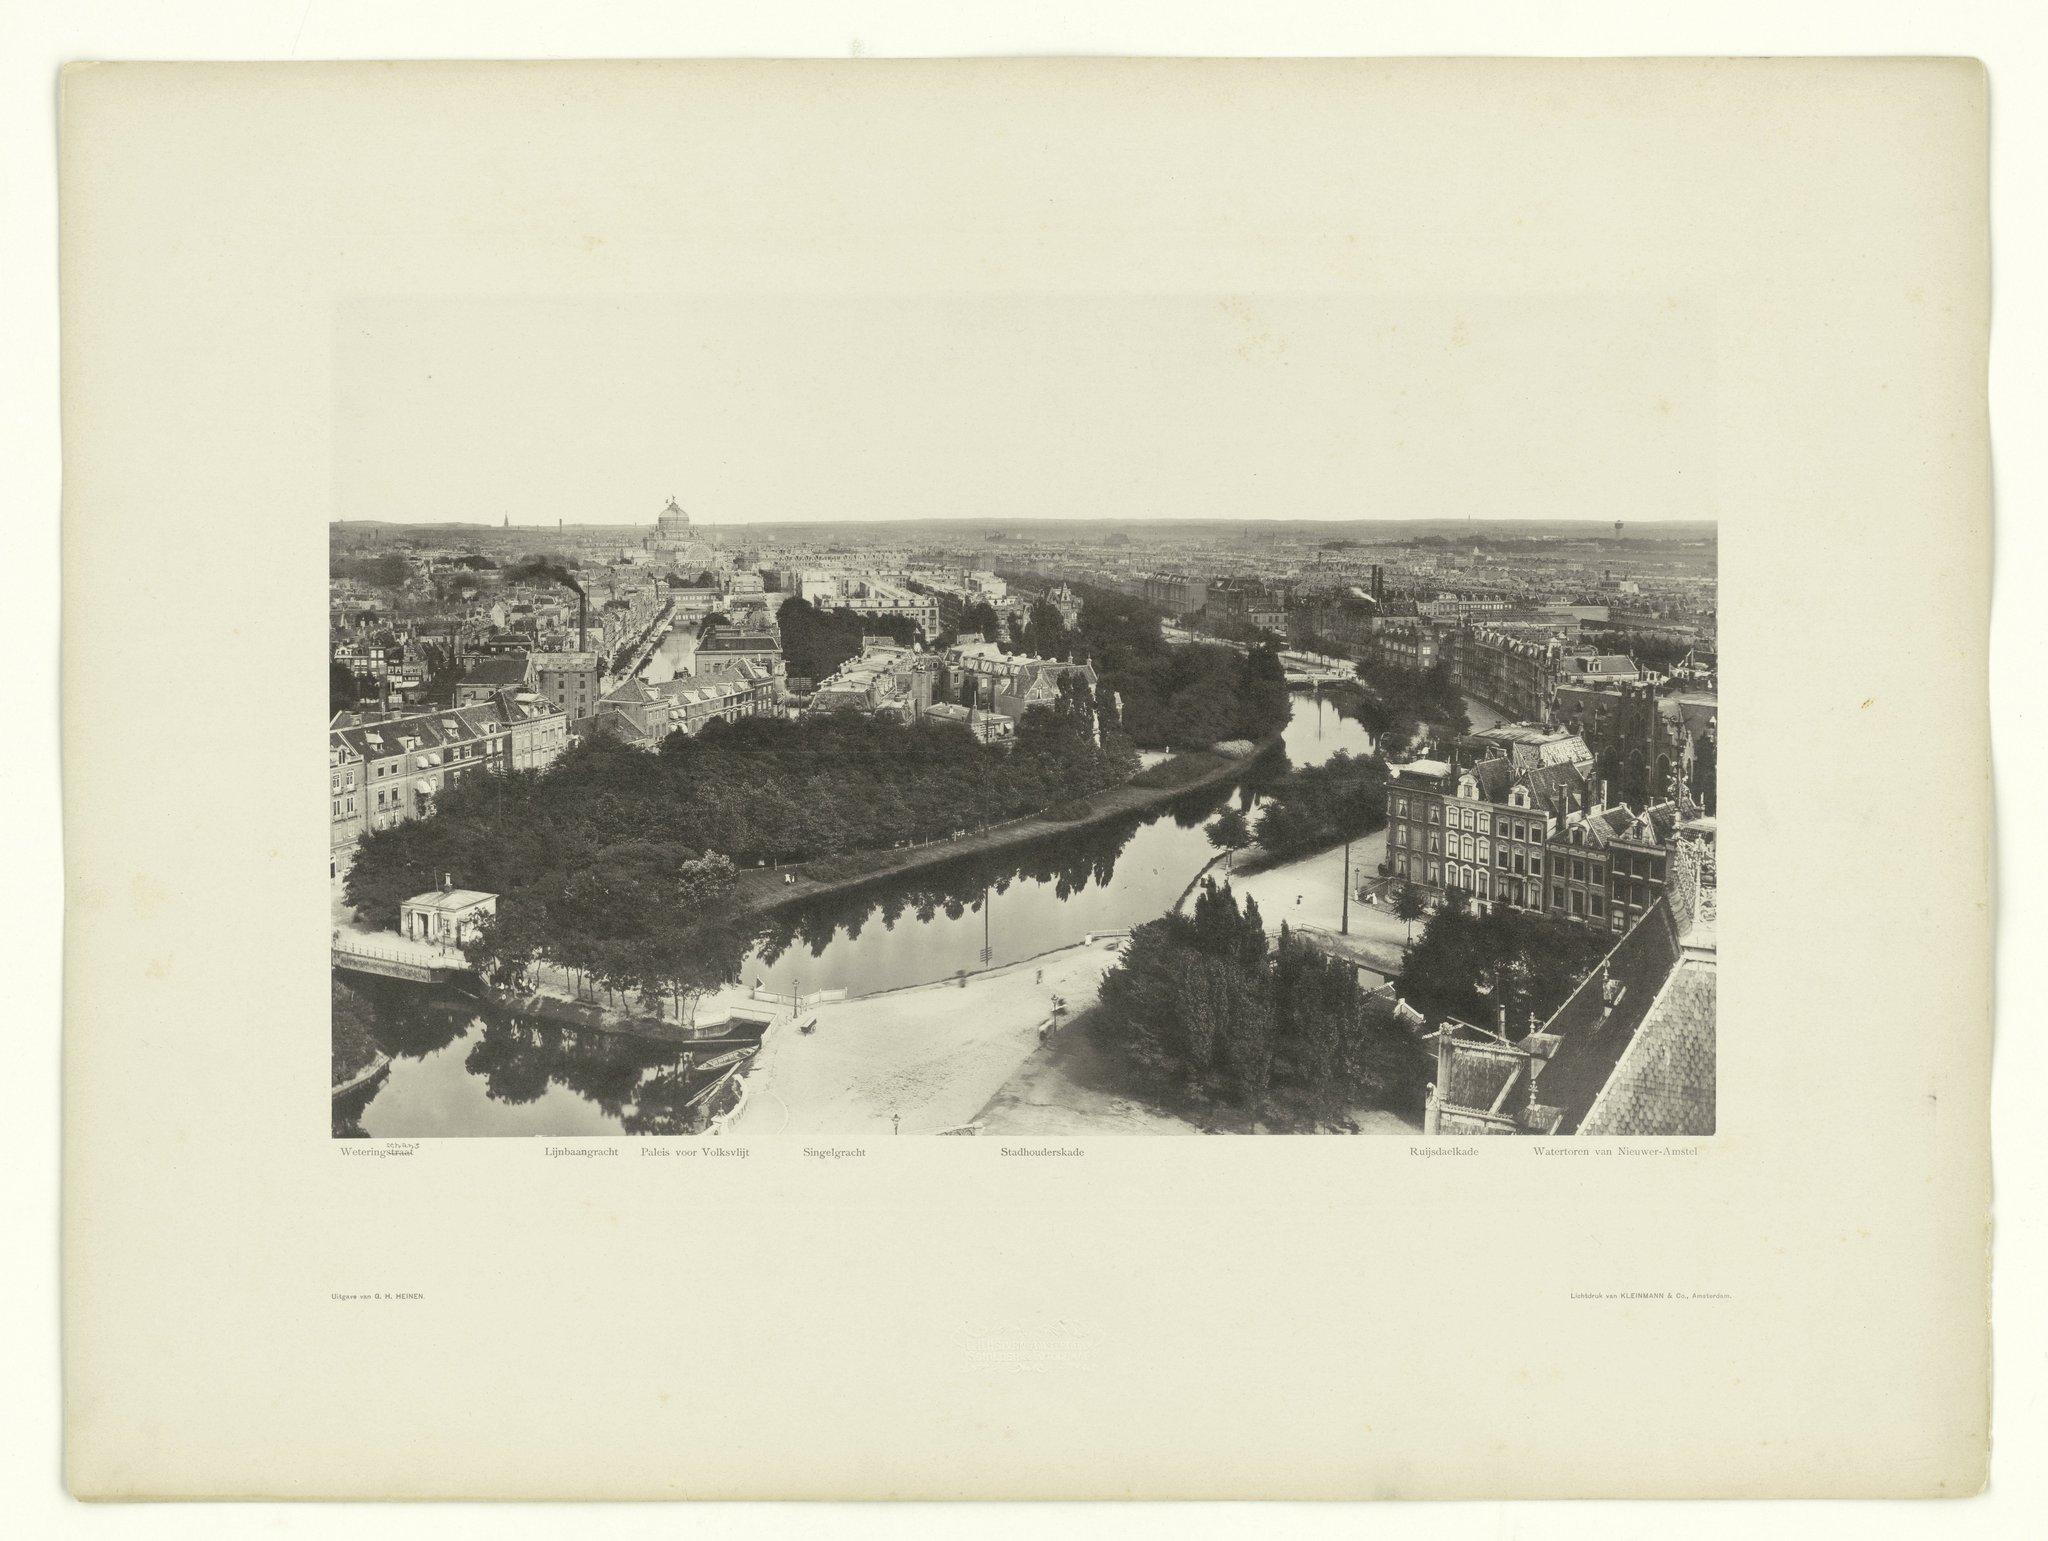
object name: photomechanical print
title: Weteringstraat, Lijnbaangracht, Paleis voor Volksvlijt, Singelgracht, Stadhouderskade, Ruijsdaelkade, Watertoren van Nieuwer-Amstel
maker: gerrit hendricus heinen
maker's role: painter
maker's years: 1851-1930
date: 1889-1894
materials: paper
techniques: photograph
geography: amsterdam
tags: city-view in general; 'veduta', canals, waters (in city)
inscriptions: check stamp: ‘G.H. Heinen Amsterdam/ Schilder & Fotograaf’, inscription: ‘schans’